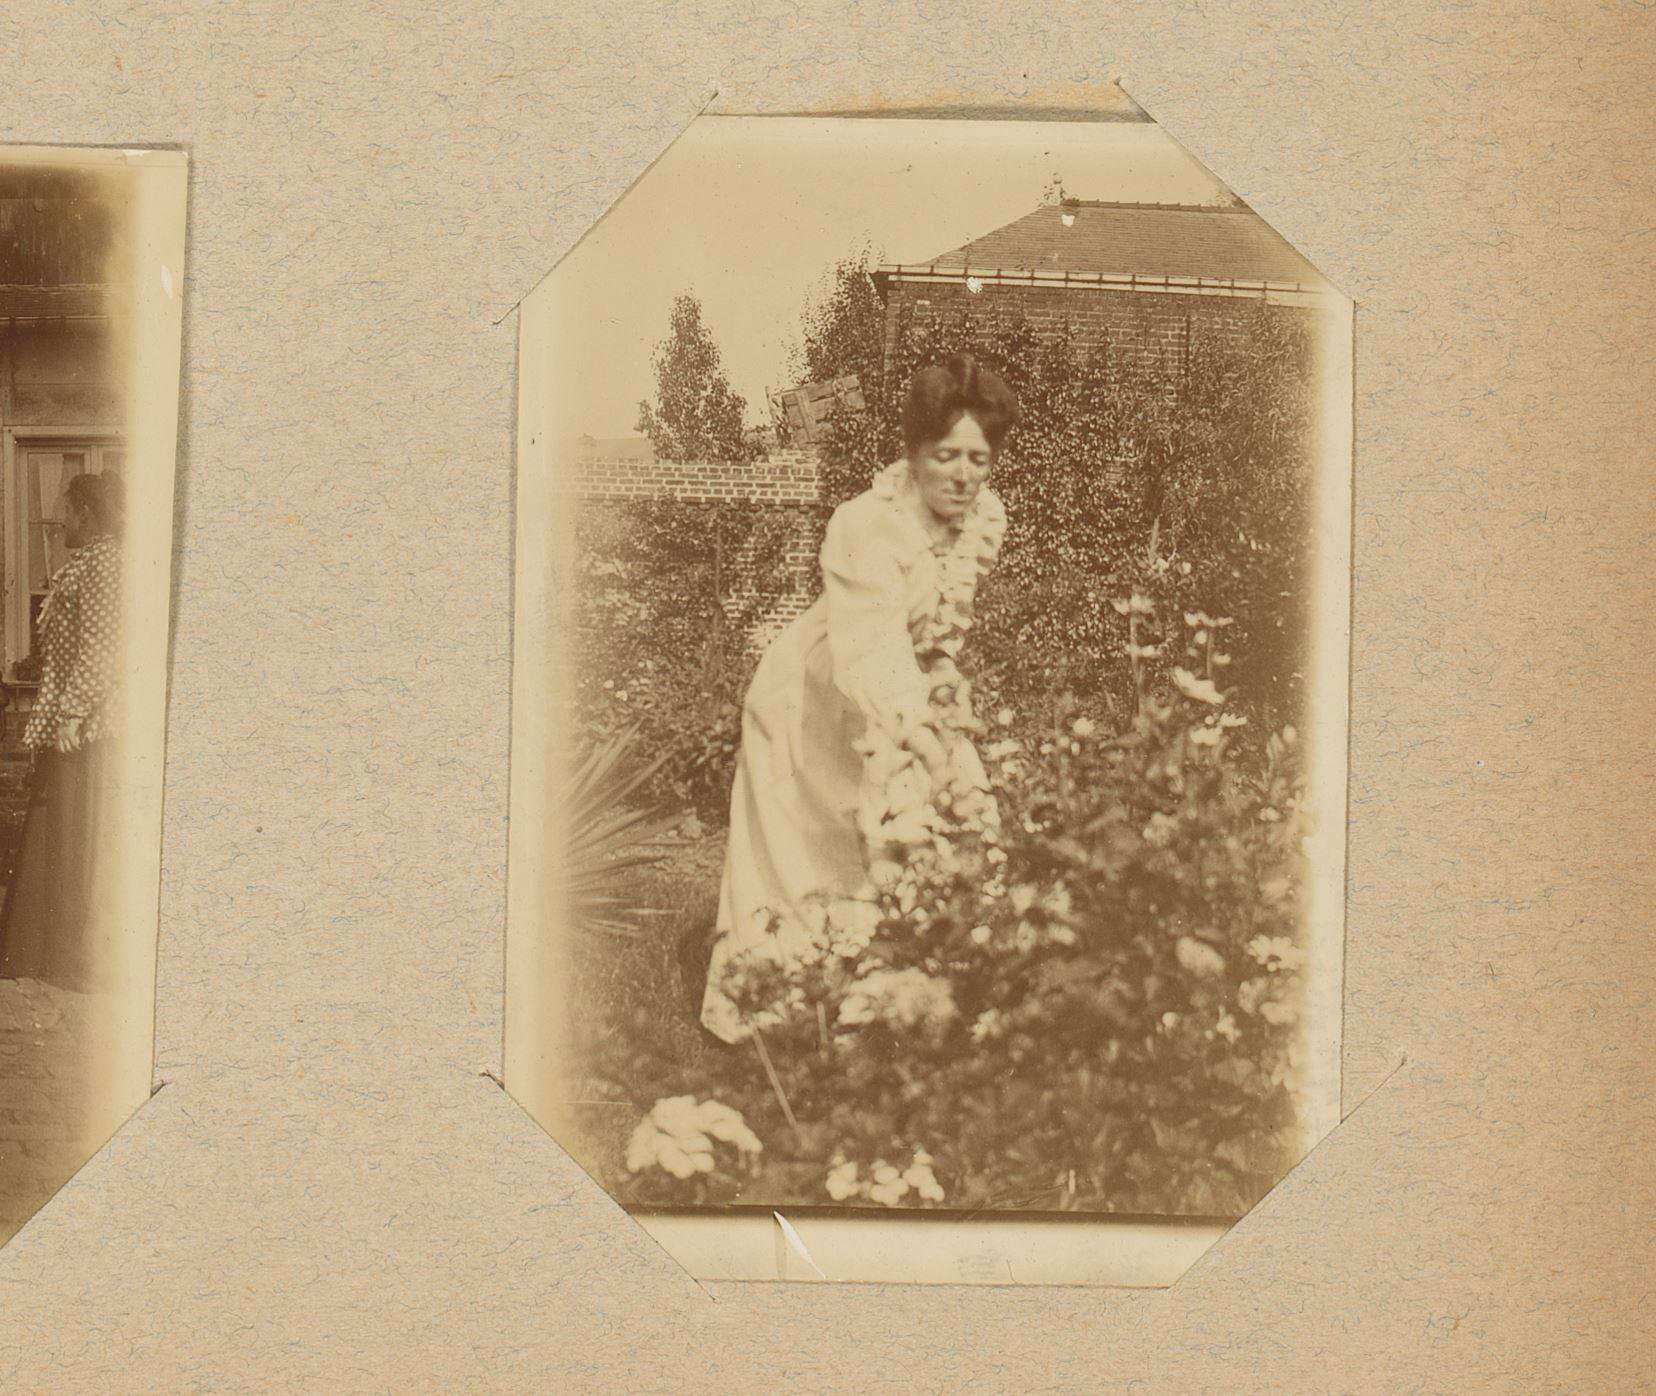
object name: album leaf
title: Vrouw bij bloemen in tuin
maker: Anonymous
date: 1897-1900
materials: paper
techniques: gelatin silver print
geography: france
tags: flowers, adult woman, garden, france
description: Over de foto is een ander negatief afgedrukt van een voorstelling van bomen.